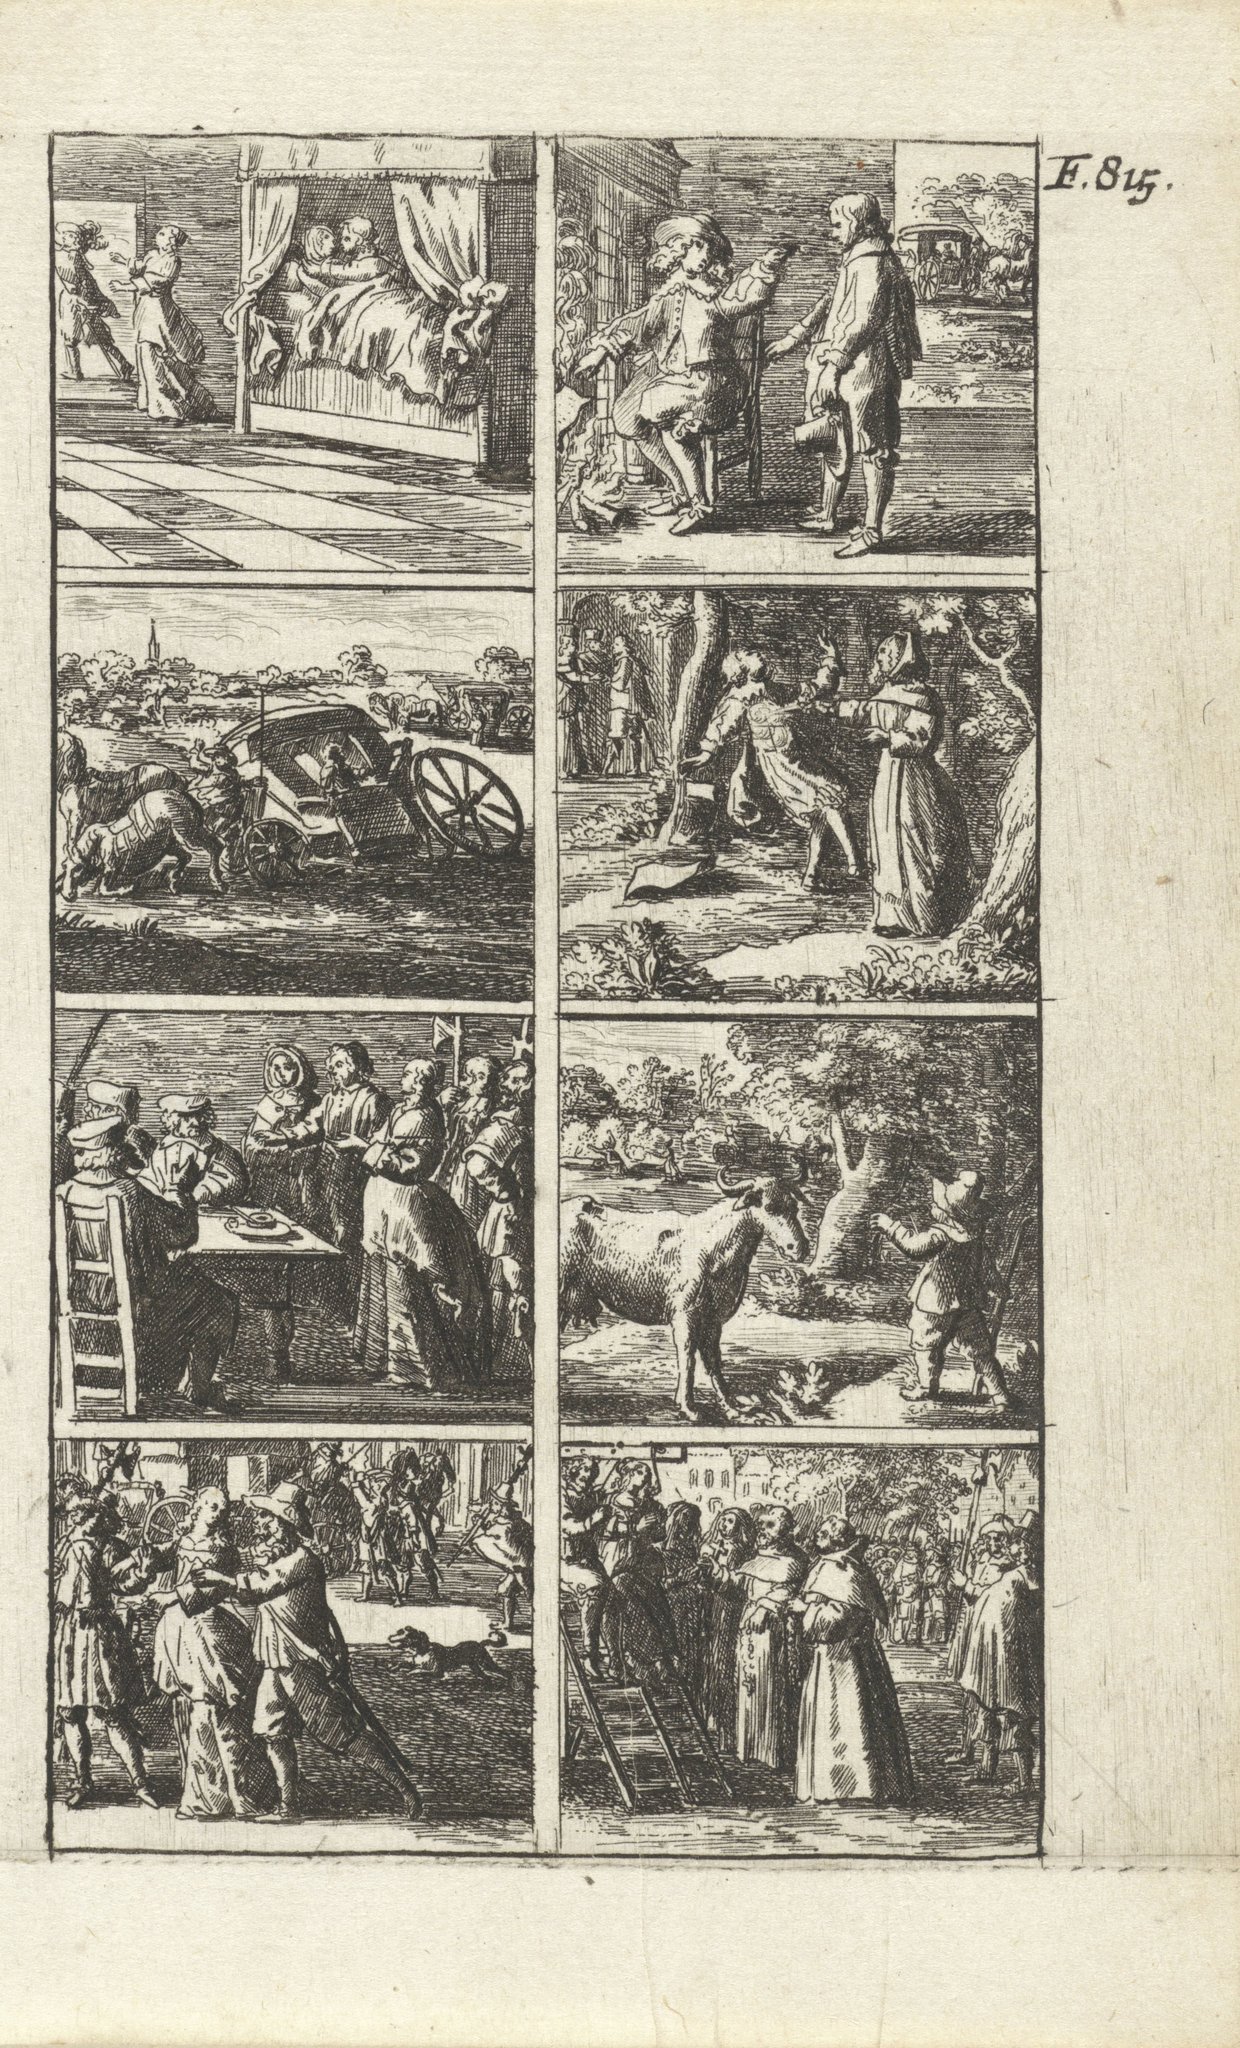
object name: print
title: Verhaal met voorstellingen van moord en doodstraf (F. 815.)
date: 1667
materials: paper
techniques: etching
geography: amsterdam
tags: death penalty, execution, murder, fighting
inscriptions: collector's mark: Lugt 2166, collector's mark: Lugt 2760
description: Verhaal in acht scènes met enkele voorstellingen van moord en doodstraf. LInksboven geliefden in bed. Daarnaast twee mannen bij een haardvuur. Links daaronder een koets in een greppel. Rechts vermoordt een vrouw een man in een bos. Daaronder een gezelschap rond een tafel en een jongen bij een koe. Linksonder enkele mensen op een plein. Rechtsonder worden een man en een vrouw opgehangen. Rechtsboven: F. 815.